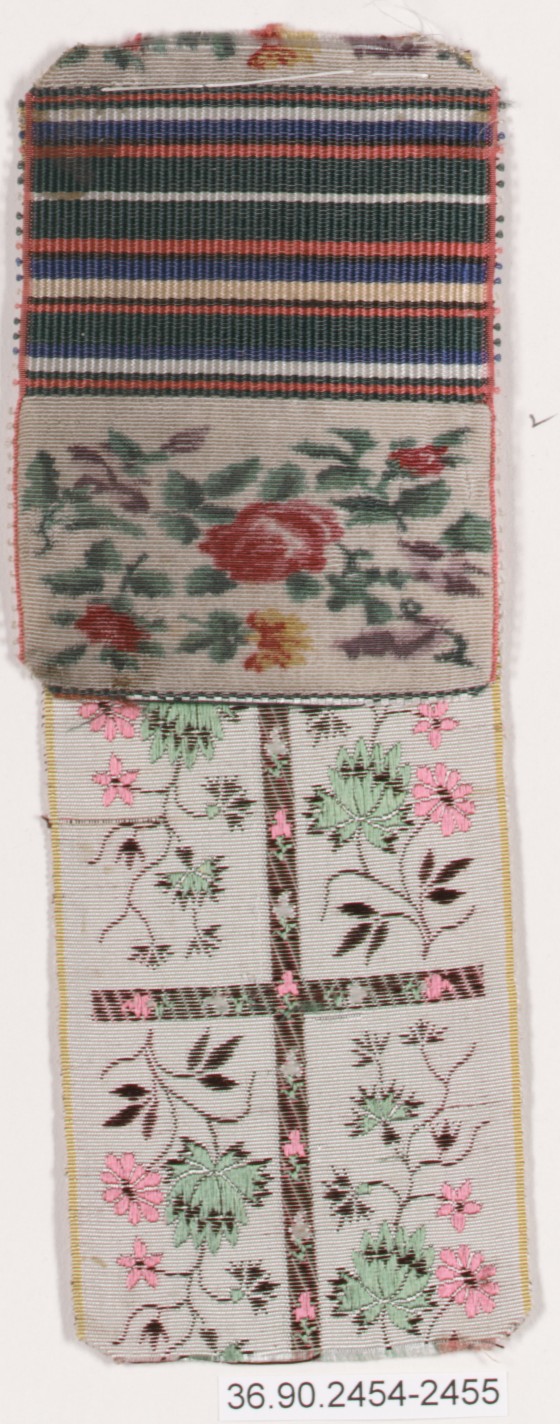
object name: ribbon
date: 1801-1900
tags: flowers